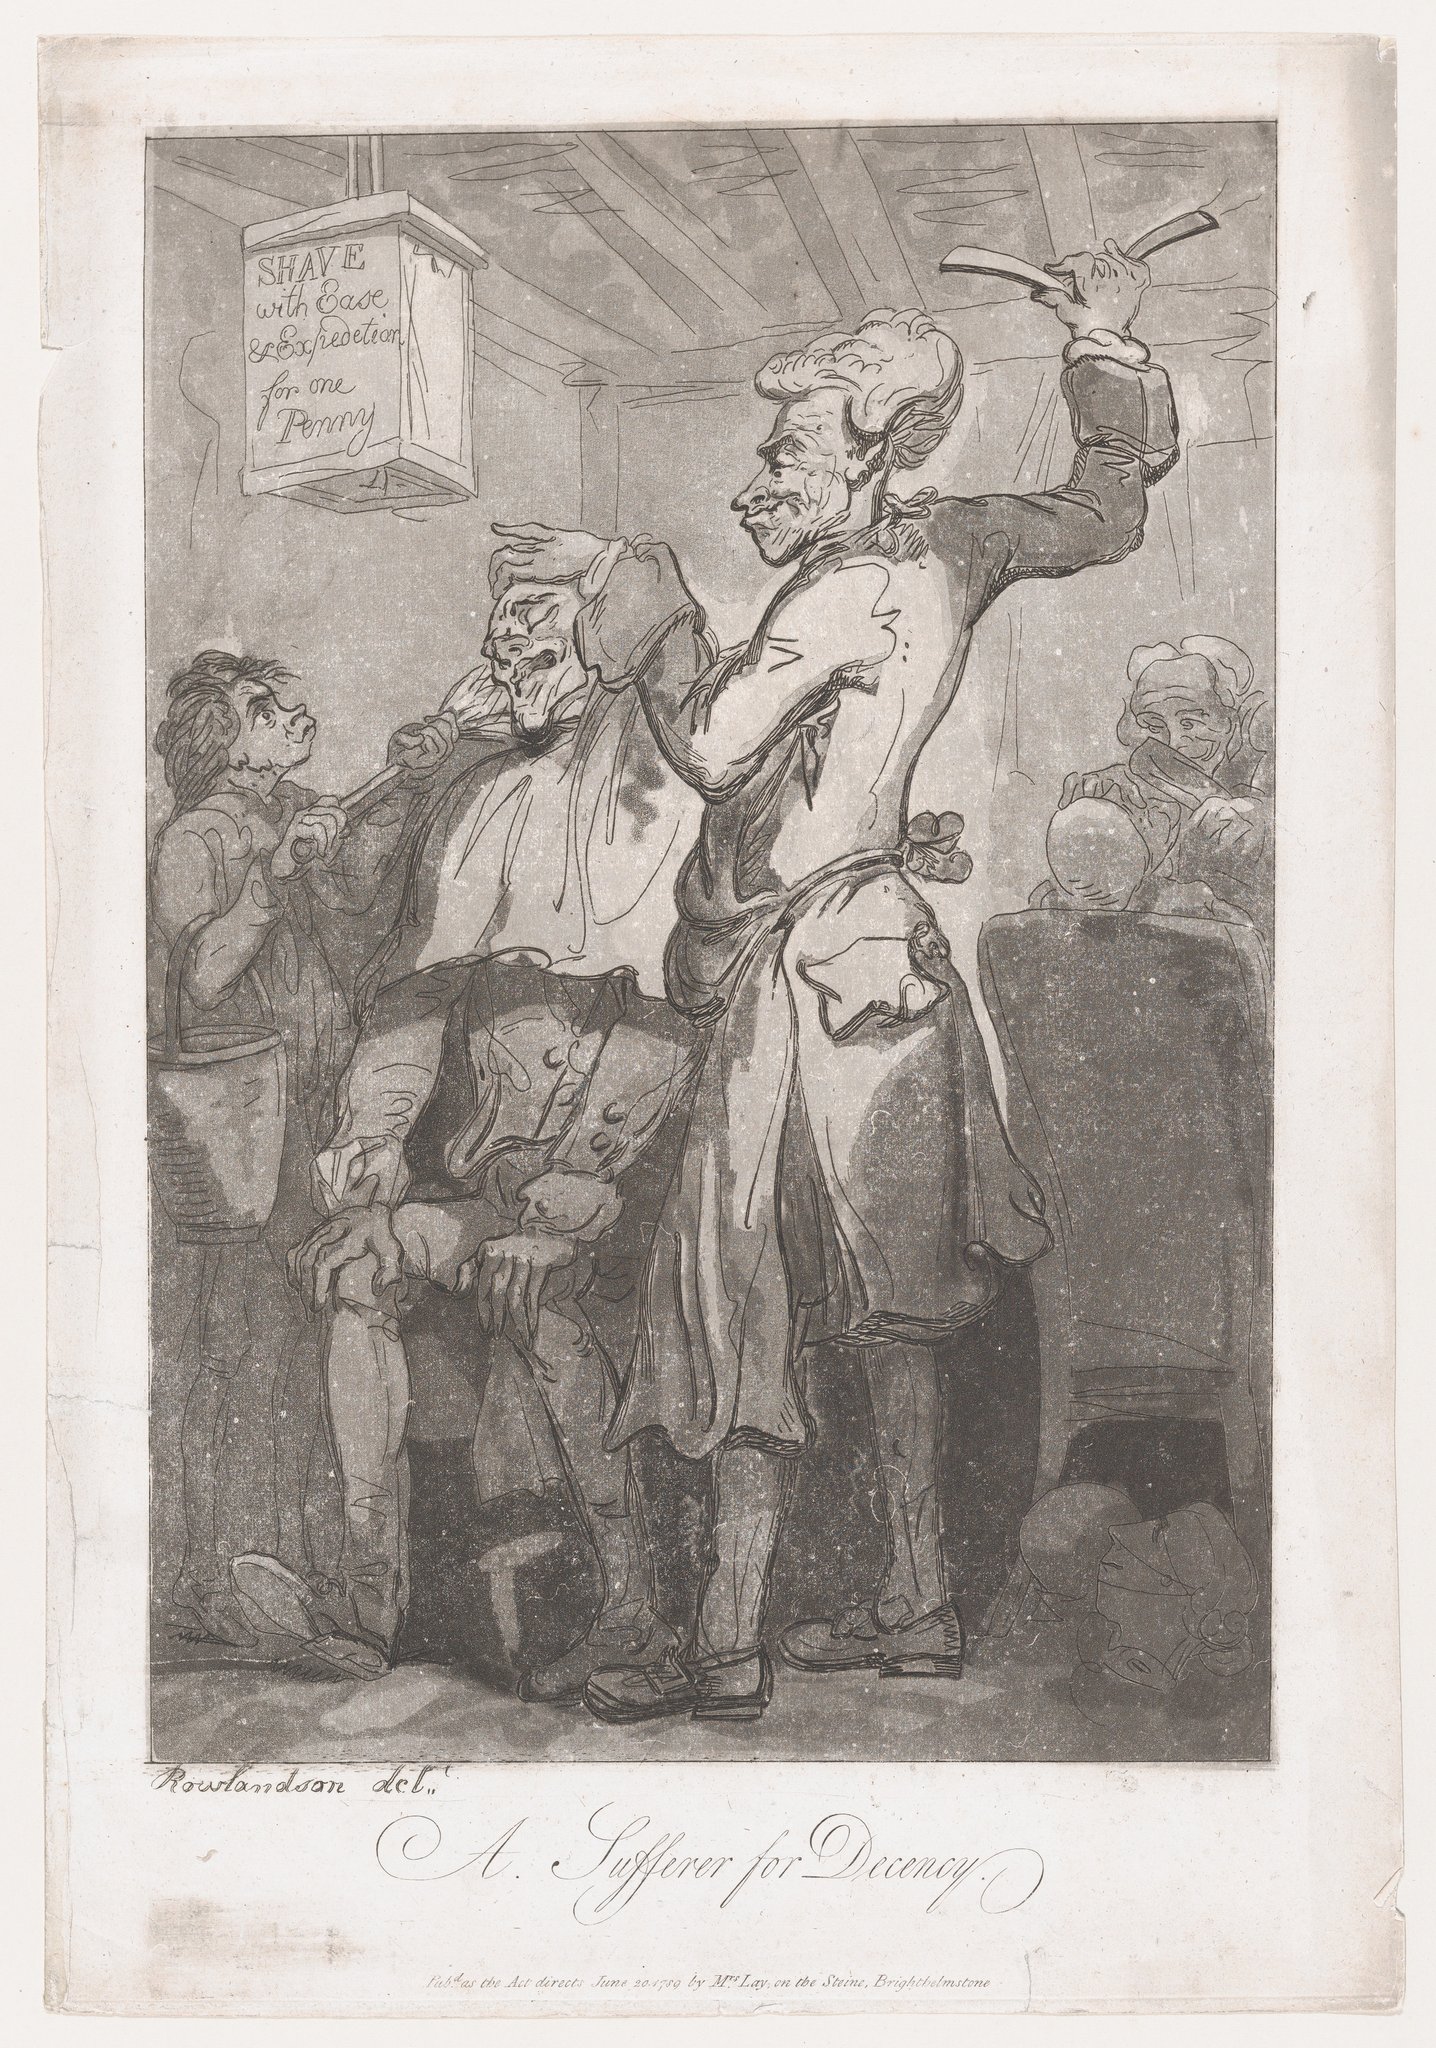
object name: print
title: A Sufferer for Decency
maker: thomas rowlandson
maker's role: artist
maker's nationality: british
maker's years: 1757-1827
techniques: aquatint, etching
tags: satire,men,barbers